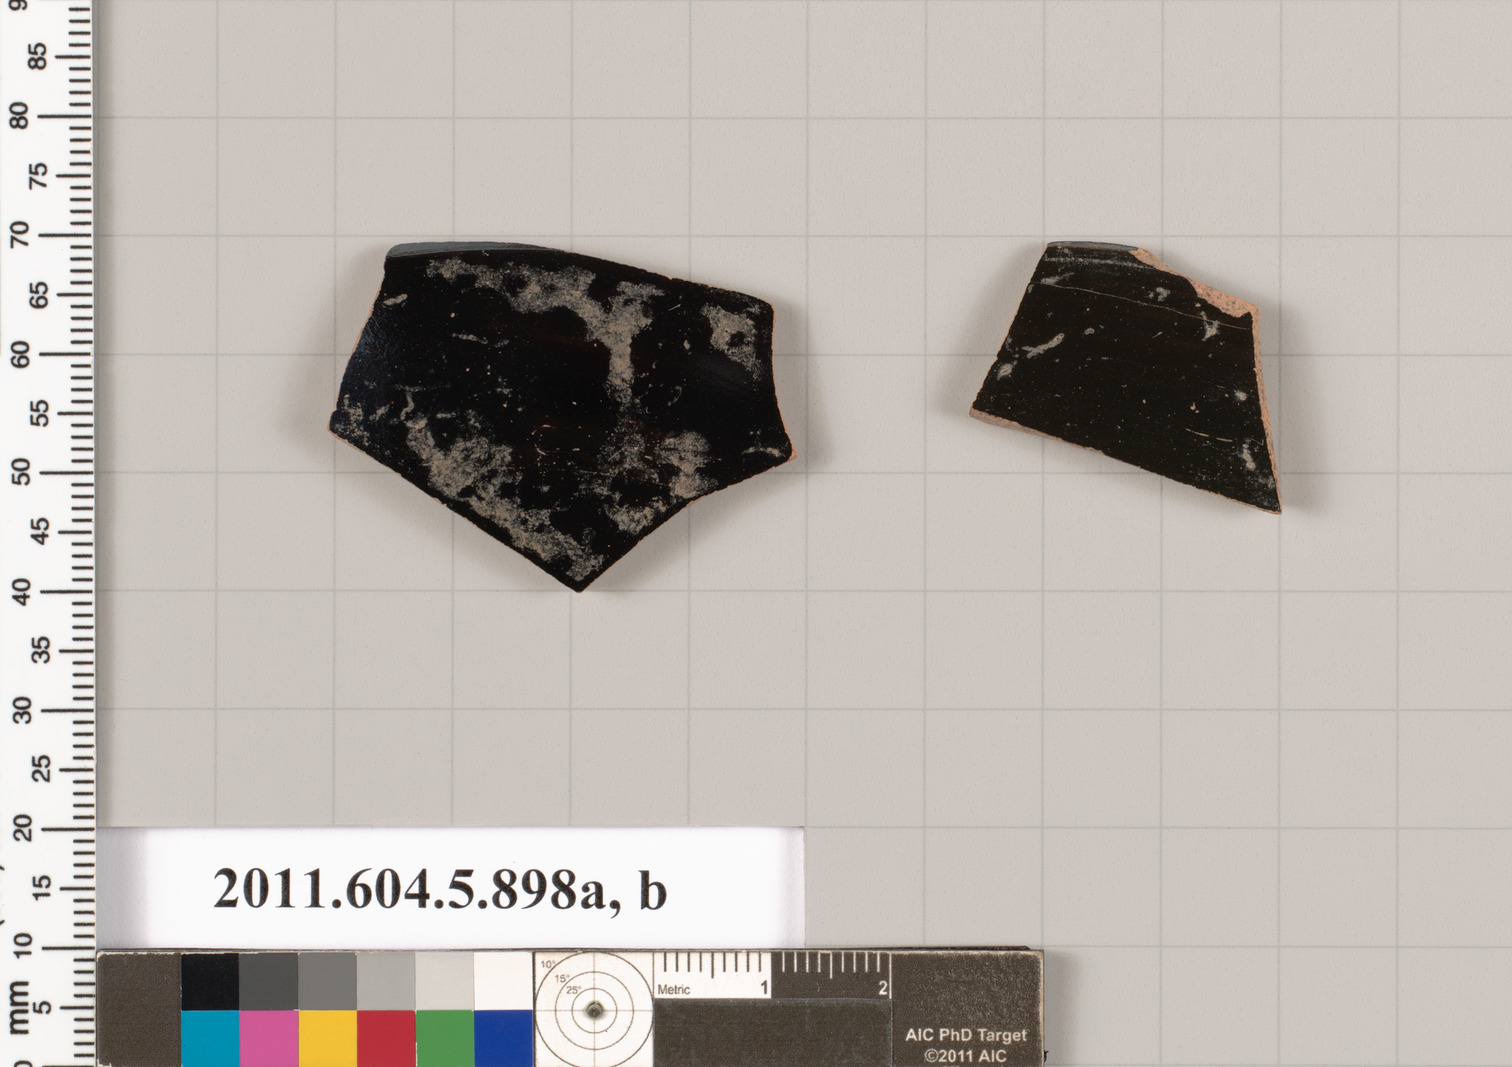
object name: kylix fragment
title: Terracotta fragments of kylikes (drinking cups)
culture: greek, attic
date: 600-401 BCE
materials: terracotta